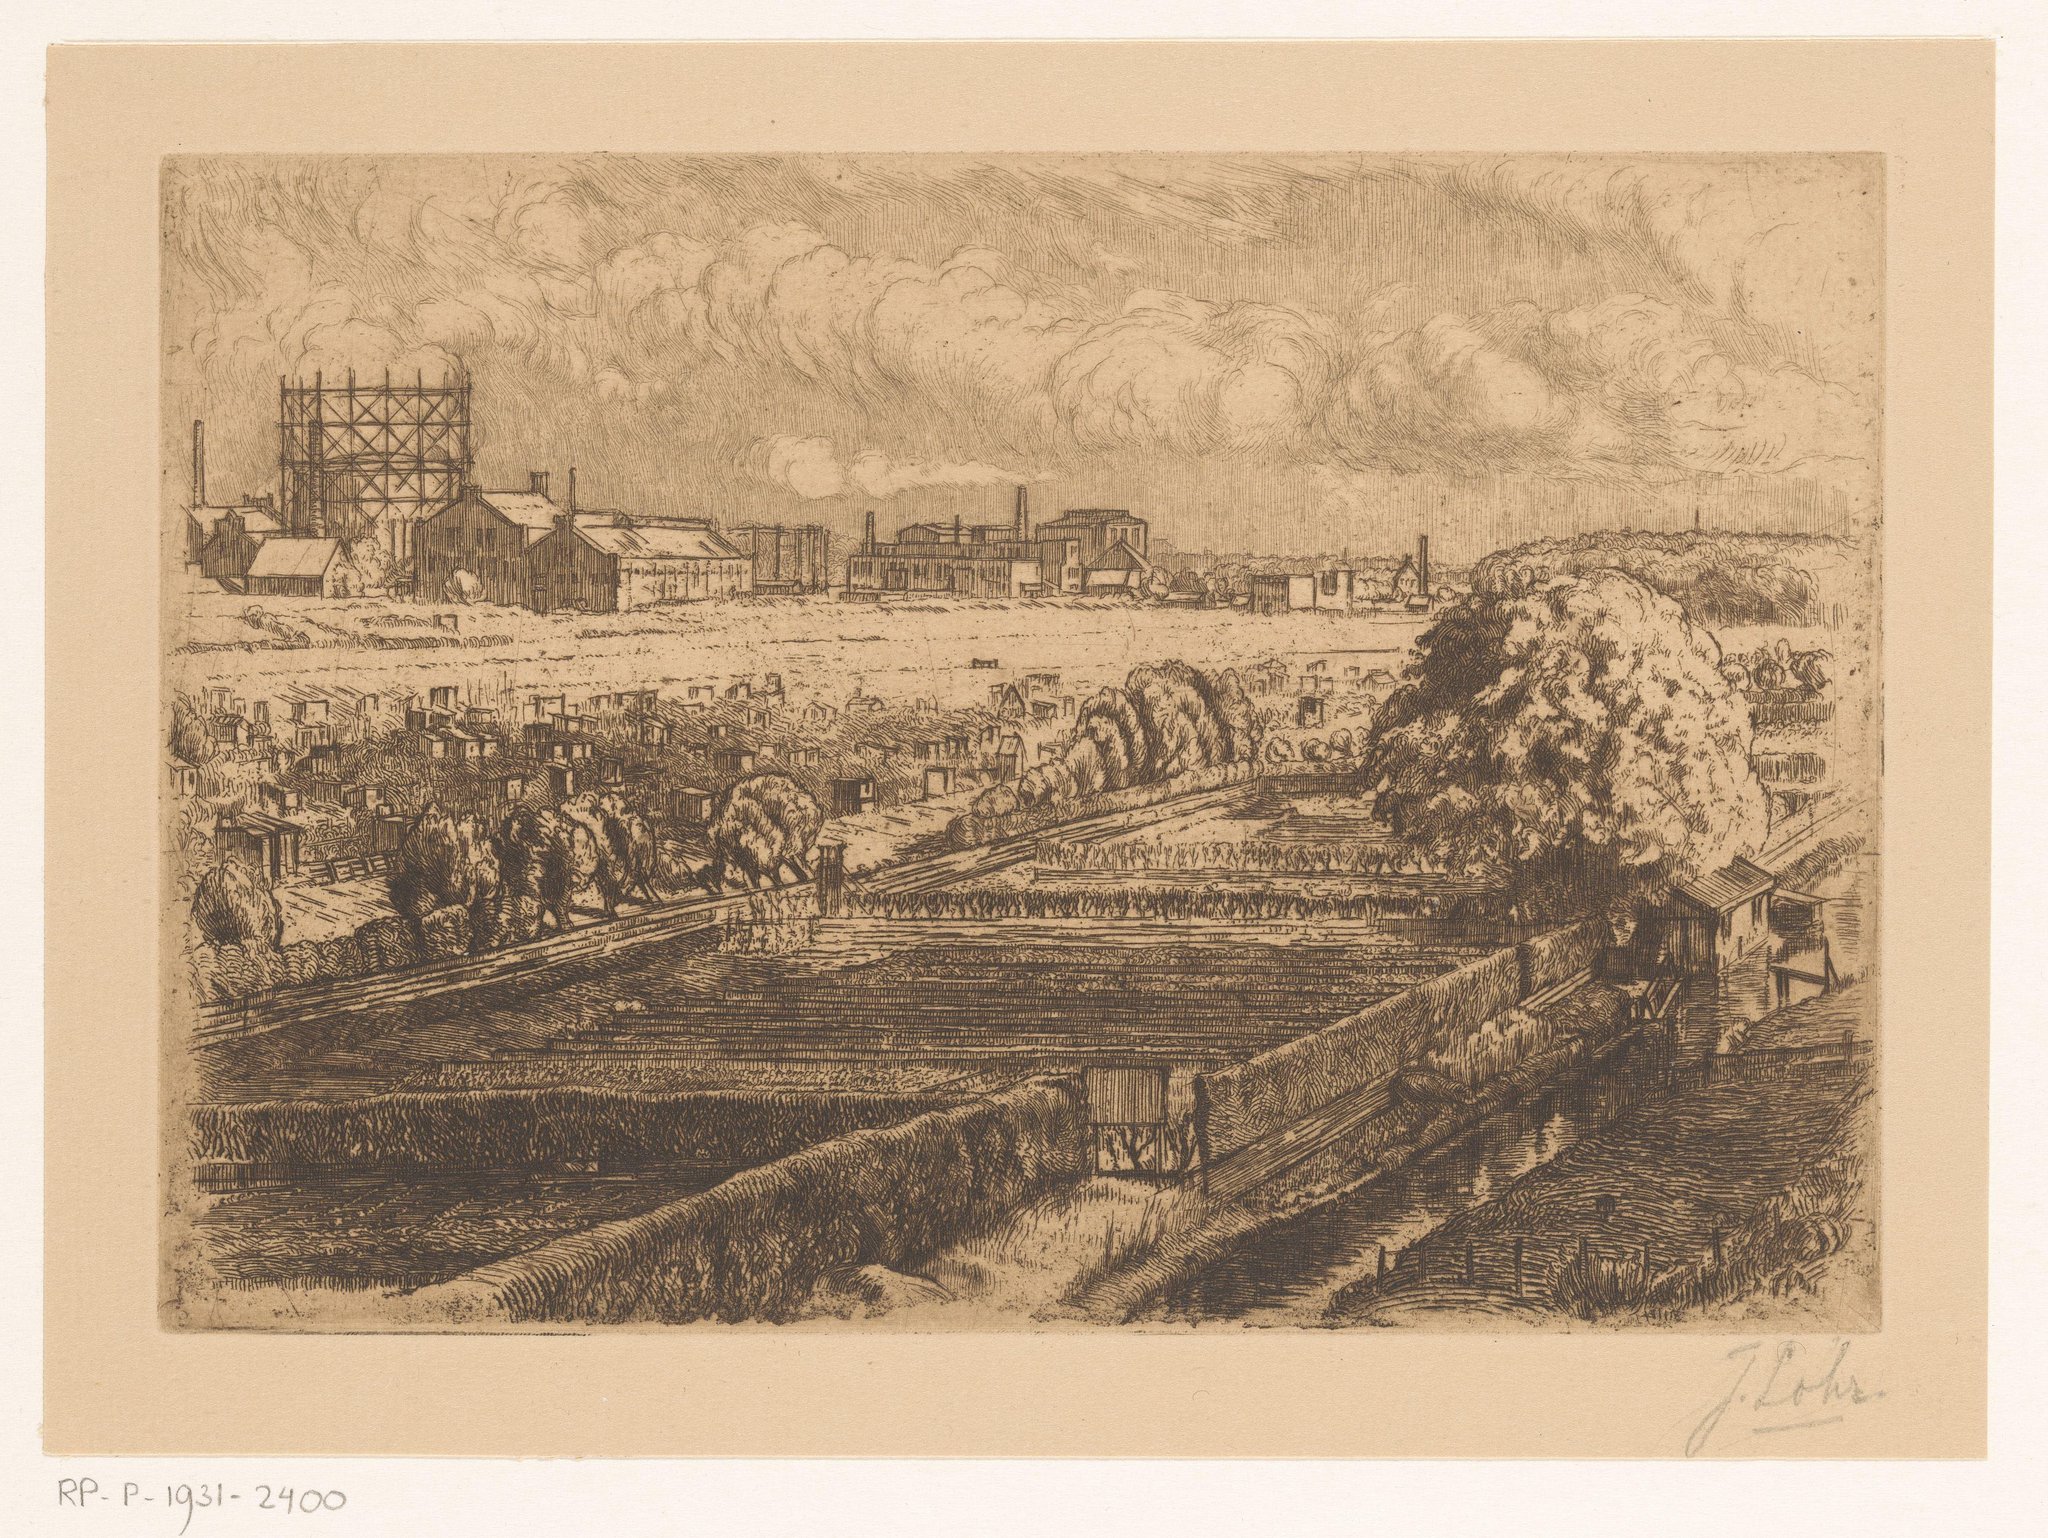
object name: print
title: Gezicht op de Slatuinen in Amsterdam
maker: johannes löhr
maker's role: print maker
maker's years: 1882-1928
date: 1892-1928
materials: paper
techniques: etching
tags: horticulture, vegetable culture, market gardening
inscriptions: collector's mark: Lugt 2228